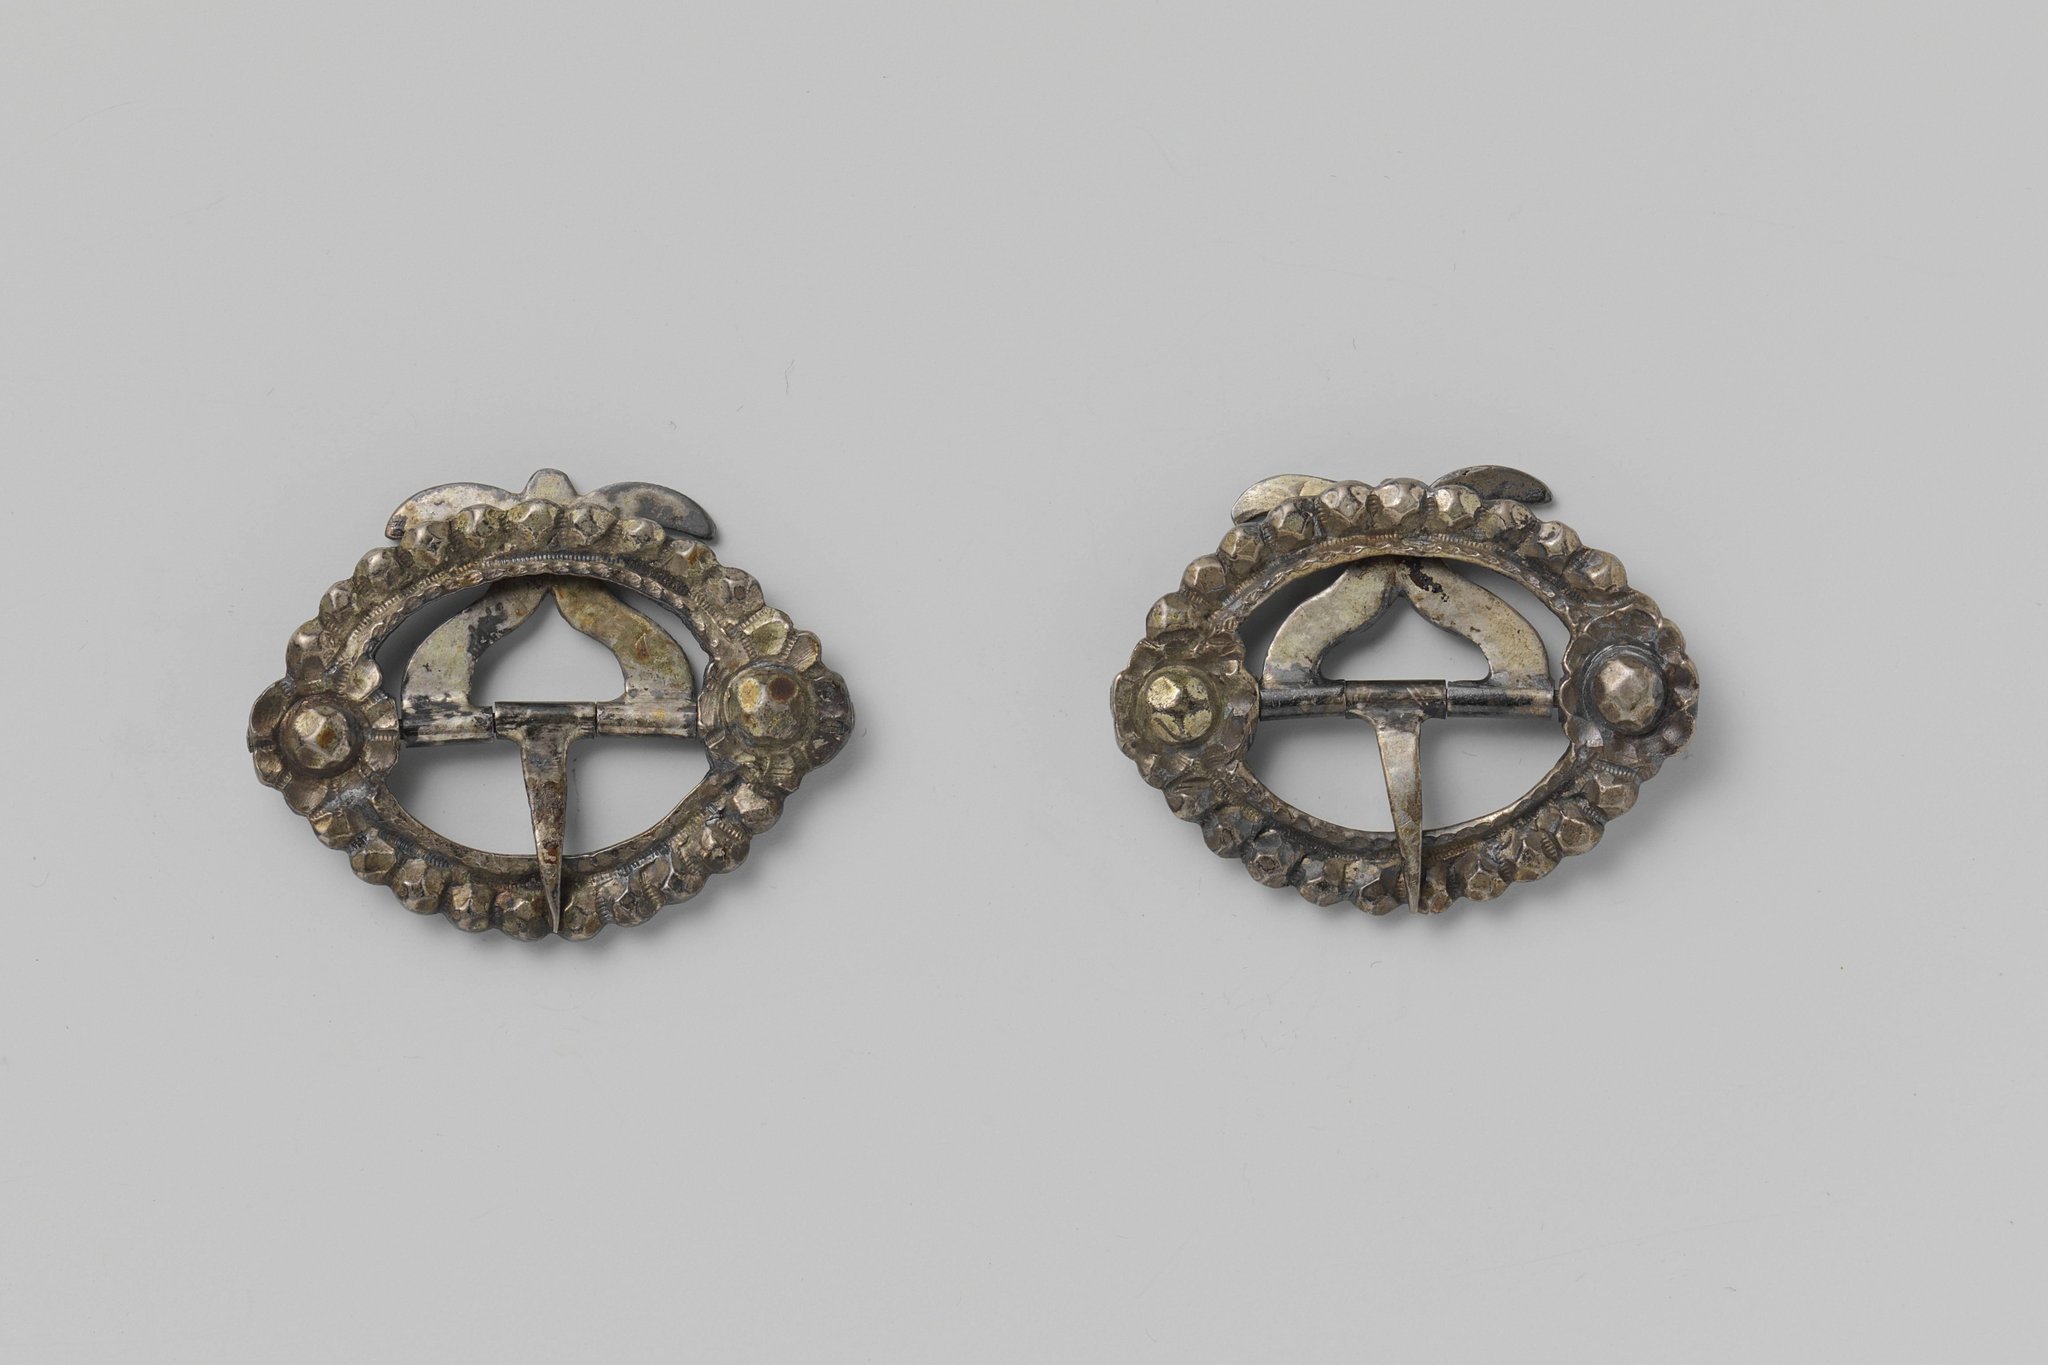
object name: buckle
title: Gesp van zilver, ovaalvormig met twee bloemen in reliëf in de hoeken van de vatting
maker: Anonymous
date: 1879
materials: silk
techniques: forging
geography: france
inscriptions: silver mark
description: Gesp van zilver, ovaalvormig met twee bloemen in reliëf in de hoeken, overige vatting diamantvormig geslepen. Scharnierende sluiting aan de achterzijde, in de vorm van een visstaart.